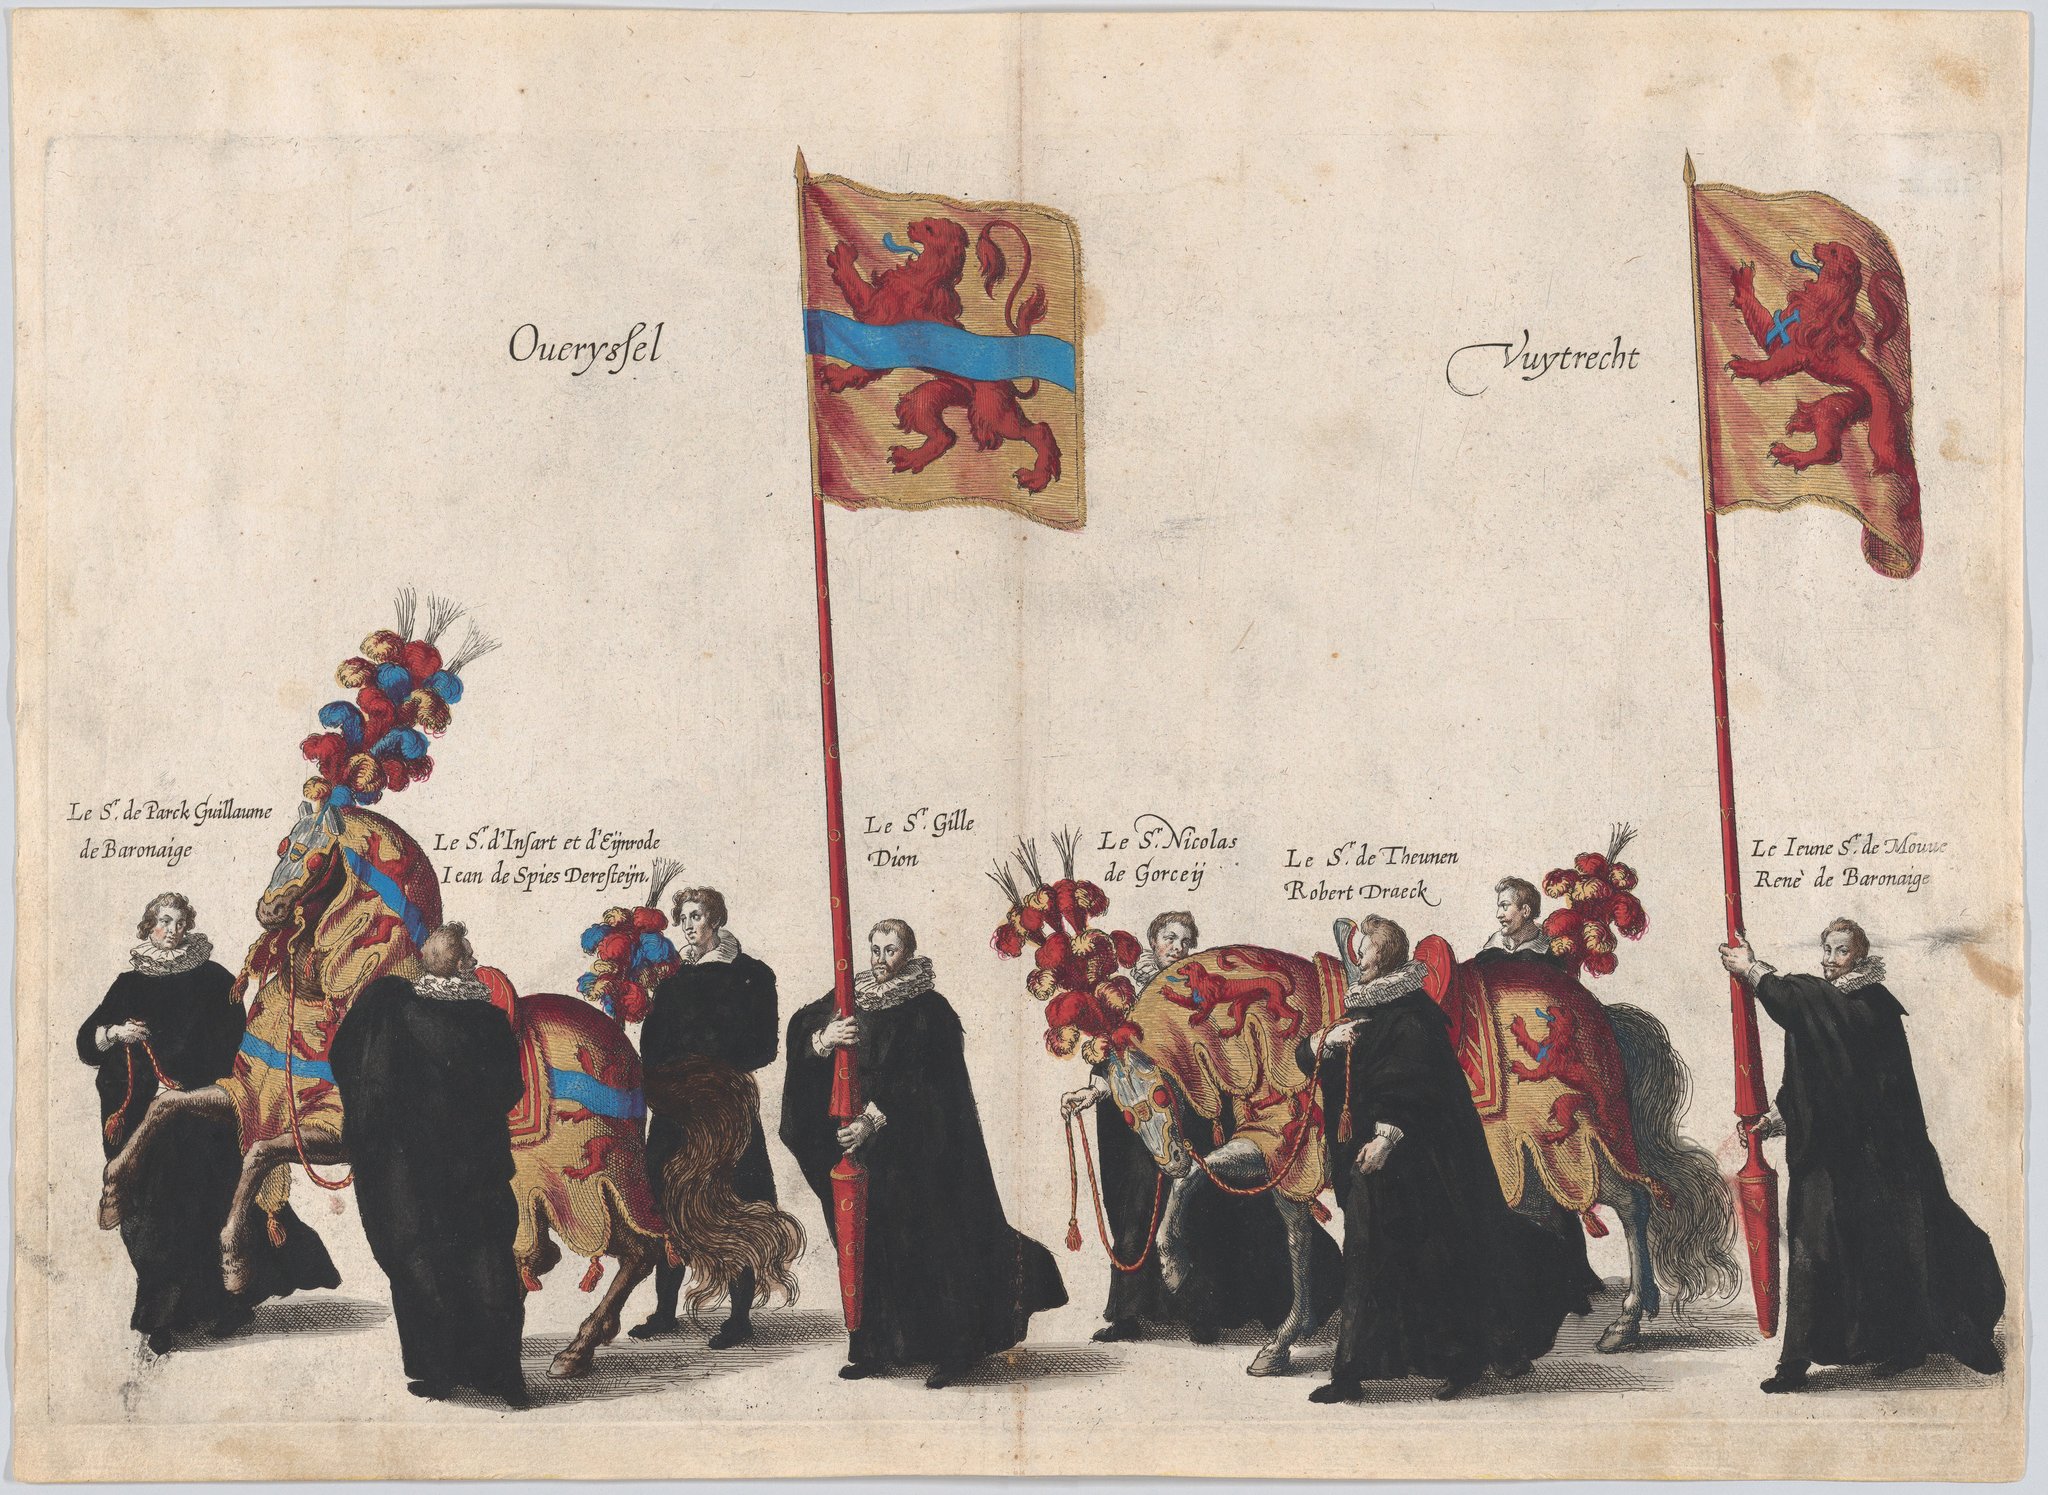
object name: print, fete, ornament architecture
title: Plate 32: Men with heraldic flags and horses from Overijssel and Utrecht marching in the funeral procession of Archduke Albert of Austria; from 'Pompa Funebris ... Alberti Pii'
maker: cornelis galle (i)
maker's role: artist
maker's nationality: netherlandish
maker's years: 1576-1650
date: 1623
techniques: etching, hand coloring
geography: brussels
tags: men,horses,funerals,coat of arms,flags